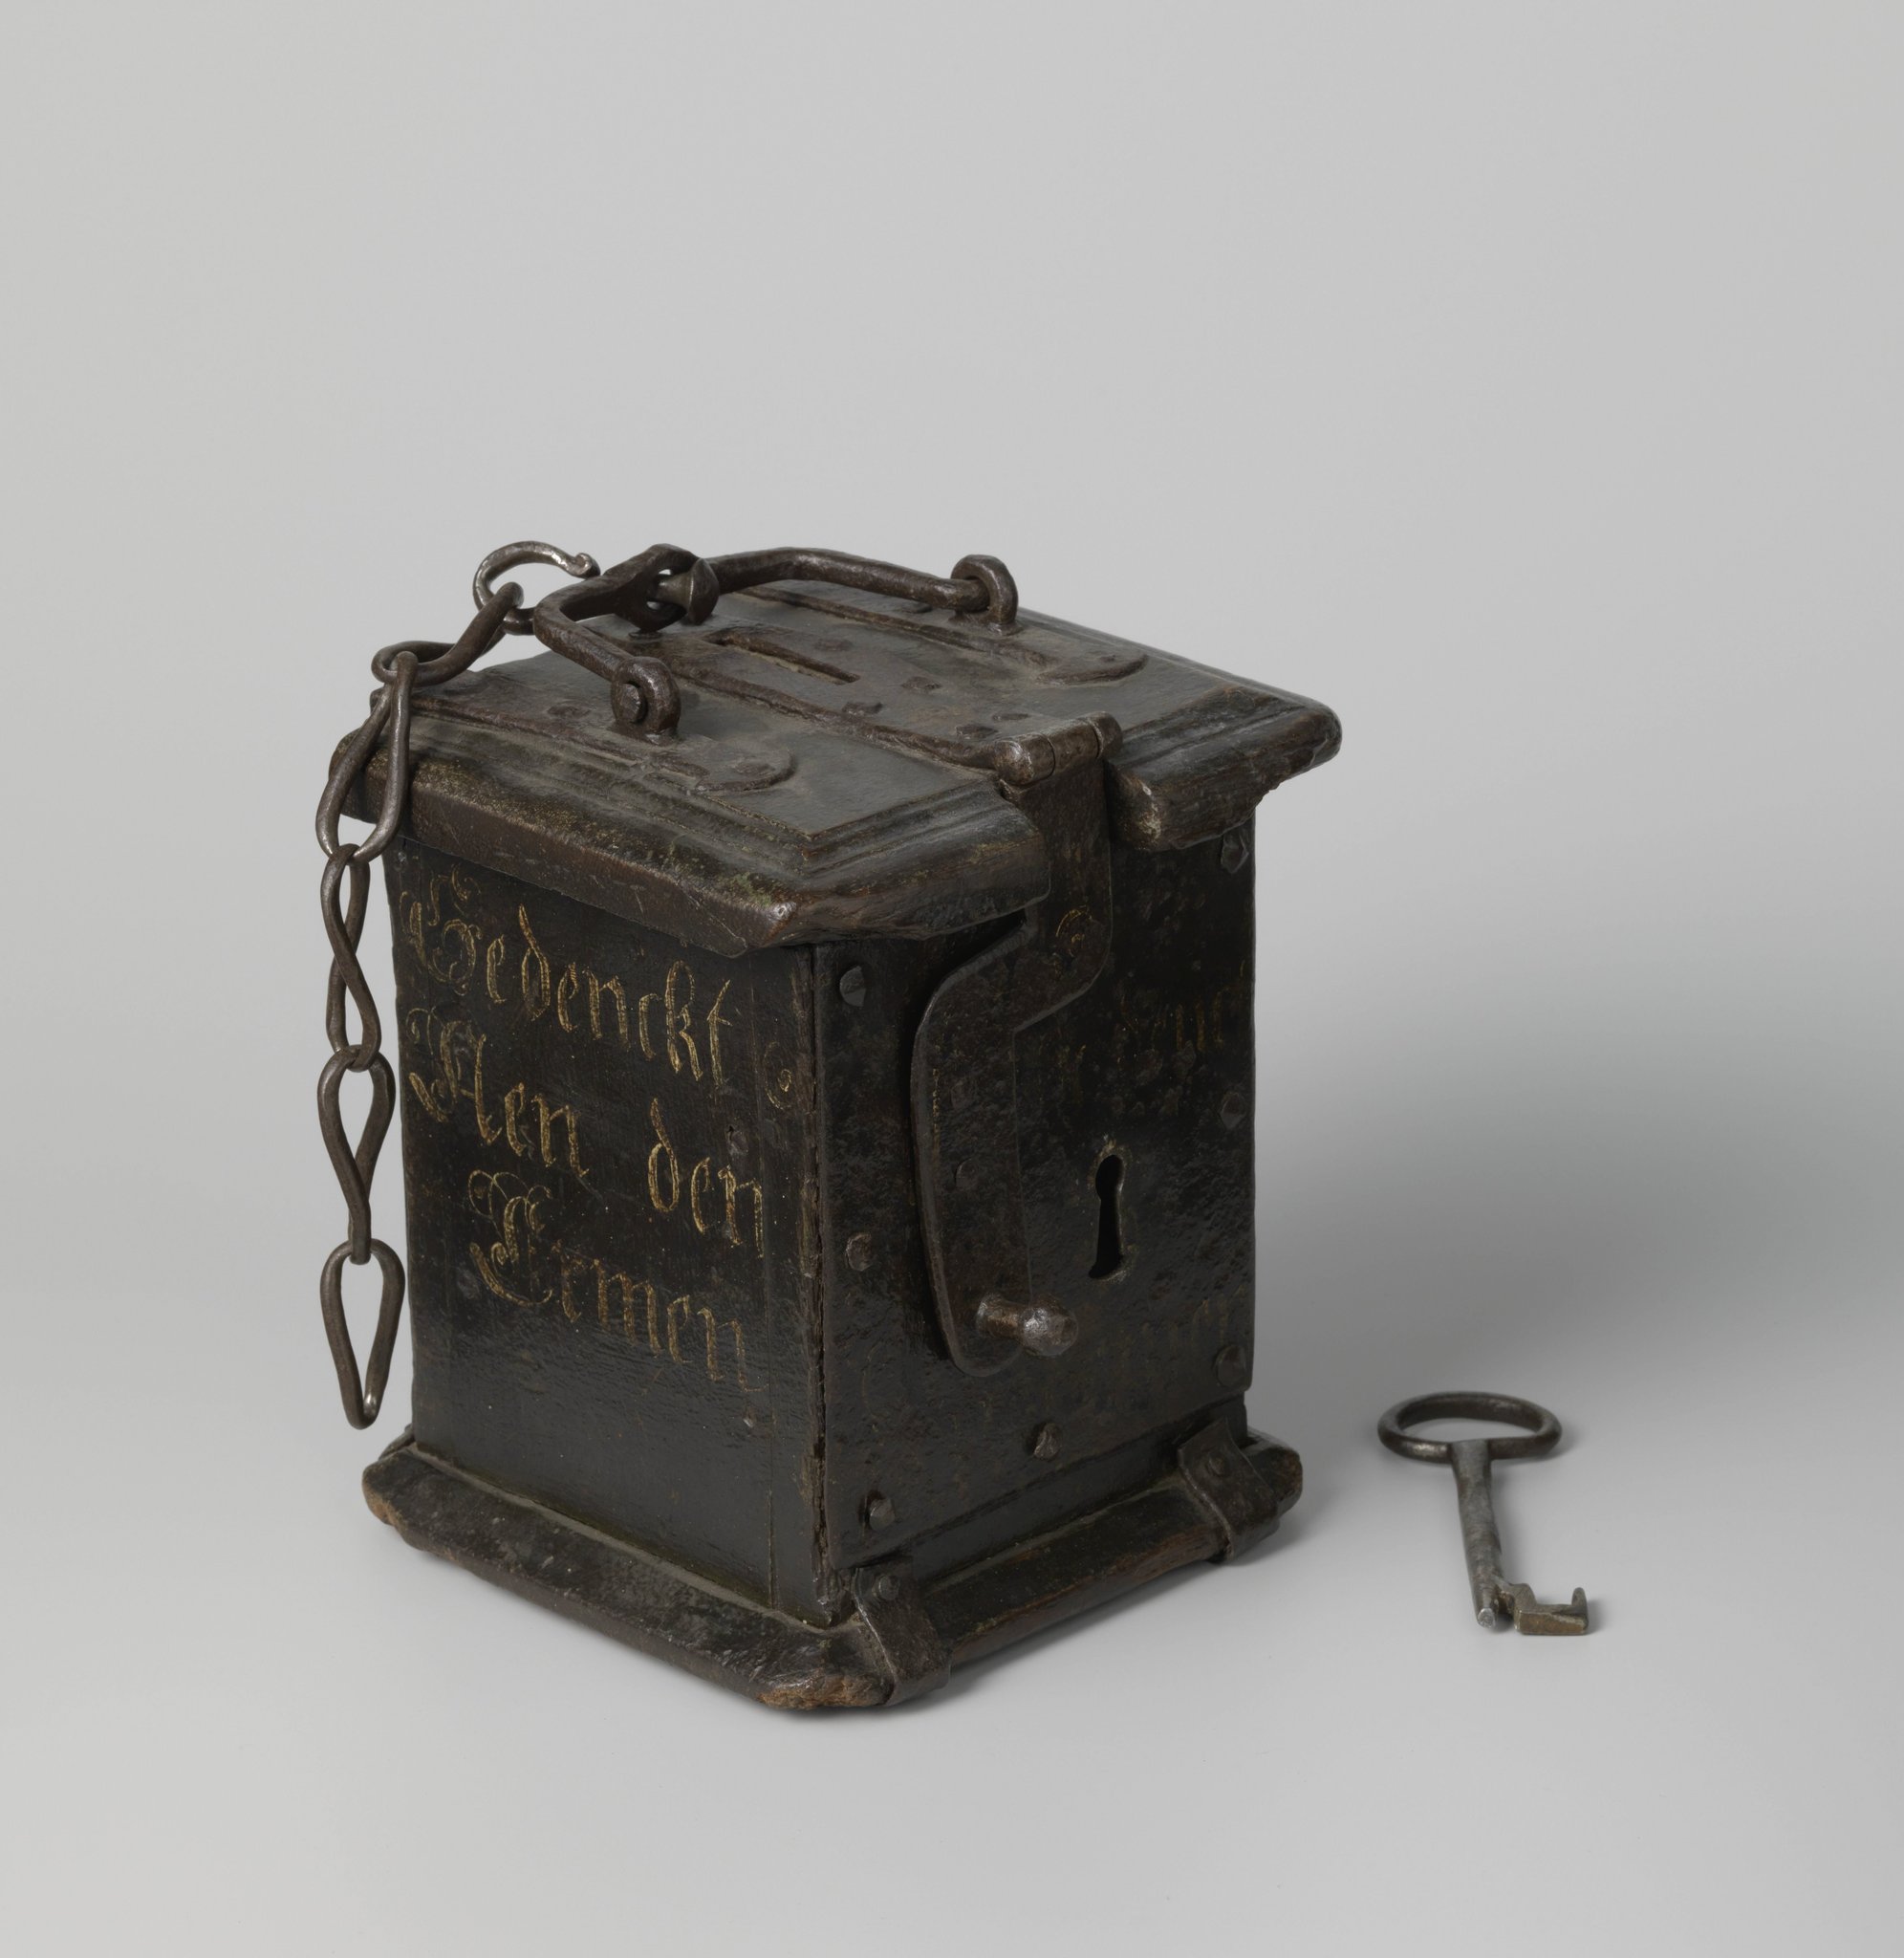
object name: offerblok, offerbus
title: Offerblok van beschilderd eikenhout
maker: Anonymous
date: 1671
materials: iron, wood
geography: northern netherlands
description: Offerblok van beschilderd eikenhout. Het blok rust op een vierkante plint en wordt afgesloten door een klapdeksel. De voorzijde wordt geheel bedekt door een met nagels op gespijkerde ijzeren slotplaat, die een sleutelgat heeft en een inlaat voor een overval die door middel van een scharnier verbonden is met de op het deksel verbonden ijzeren band waarin een gleuf. Links en rechts hiervan twee smalle ijzeren banden die verbonden zijn door een hengsel waaraan een ketting hangt en de onderkant van het blok. Op de zijkanten en op de achterkant staat geschreven: Gedenkt den armen, 1671.